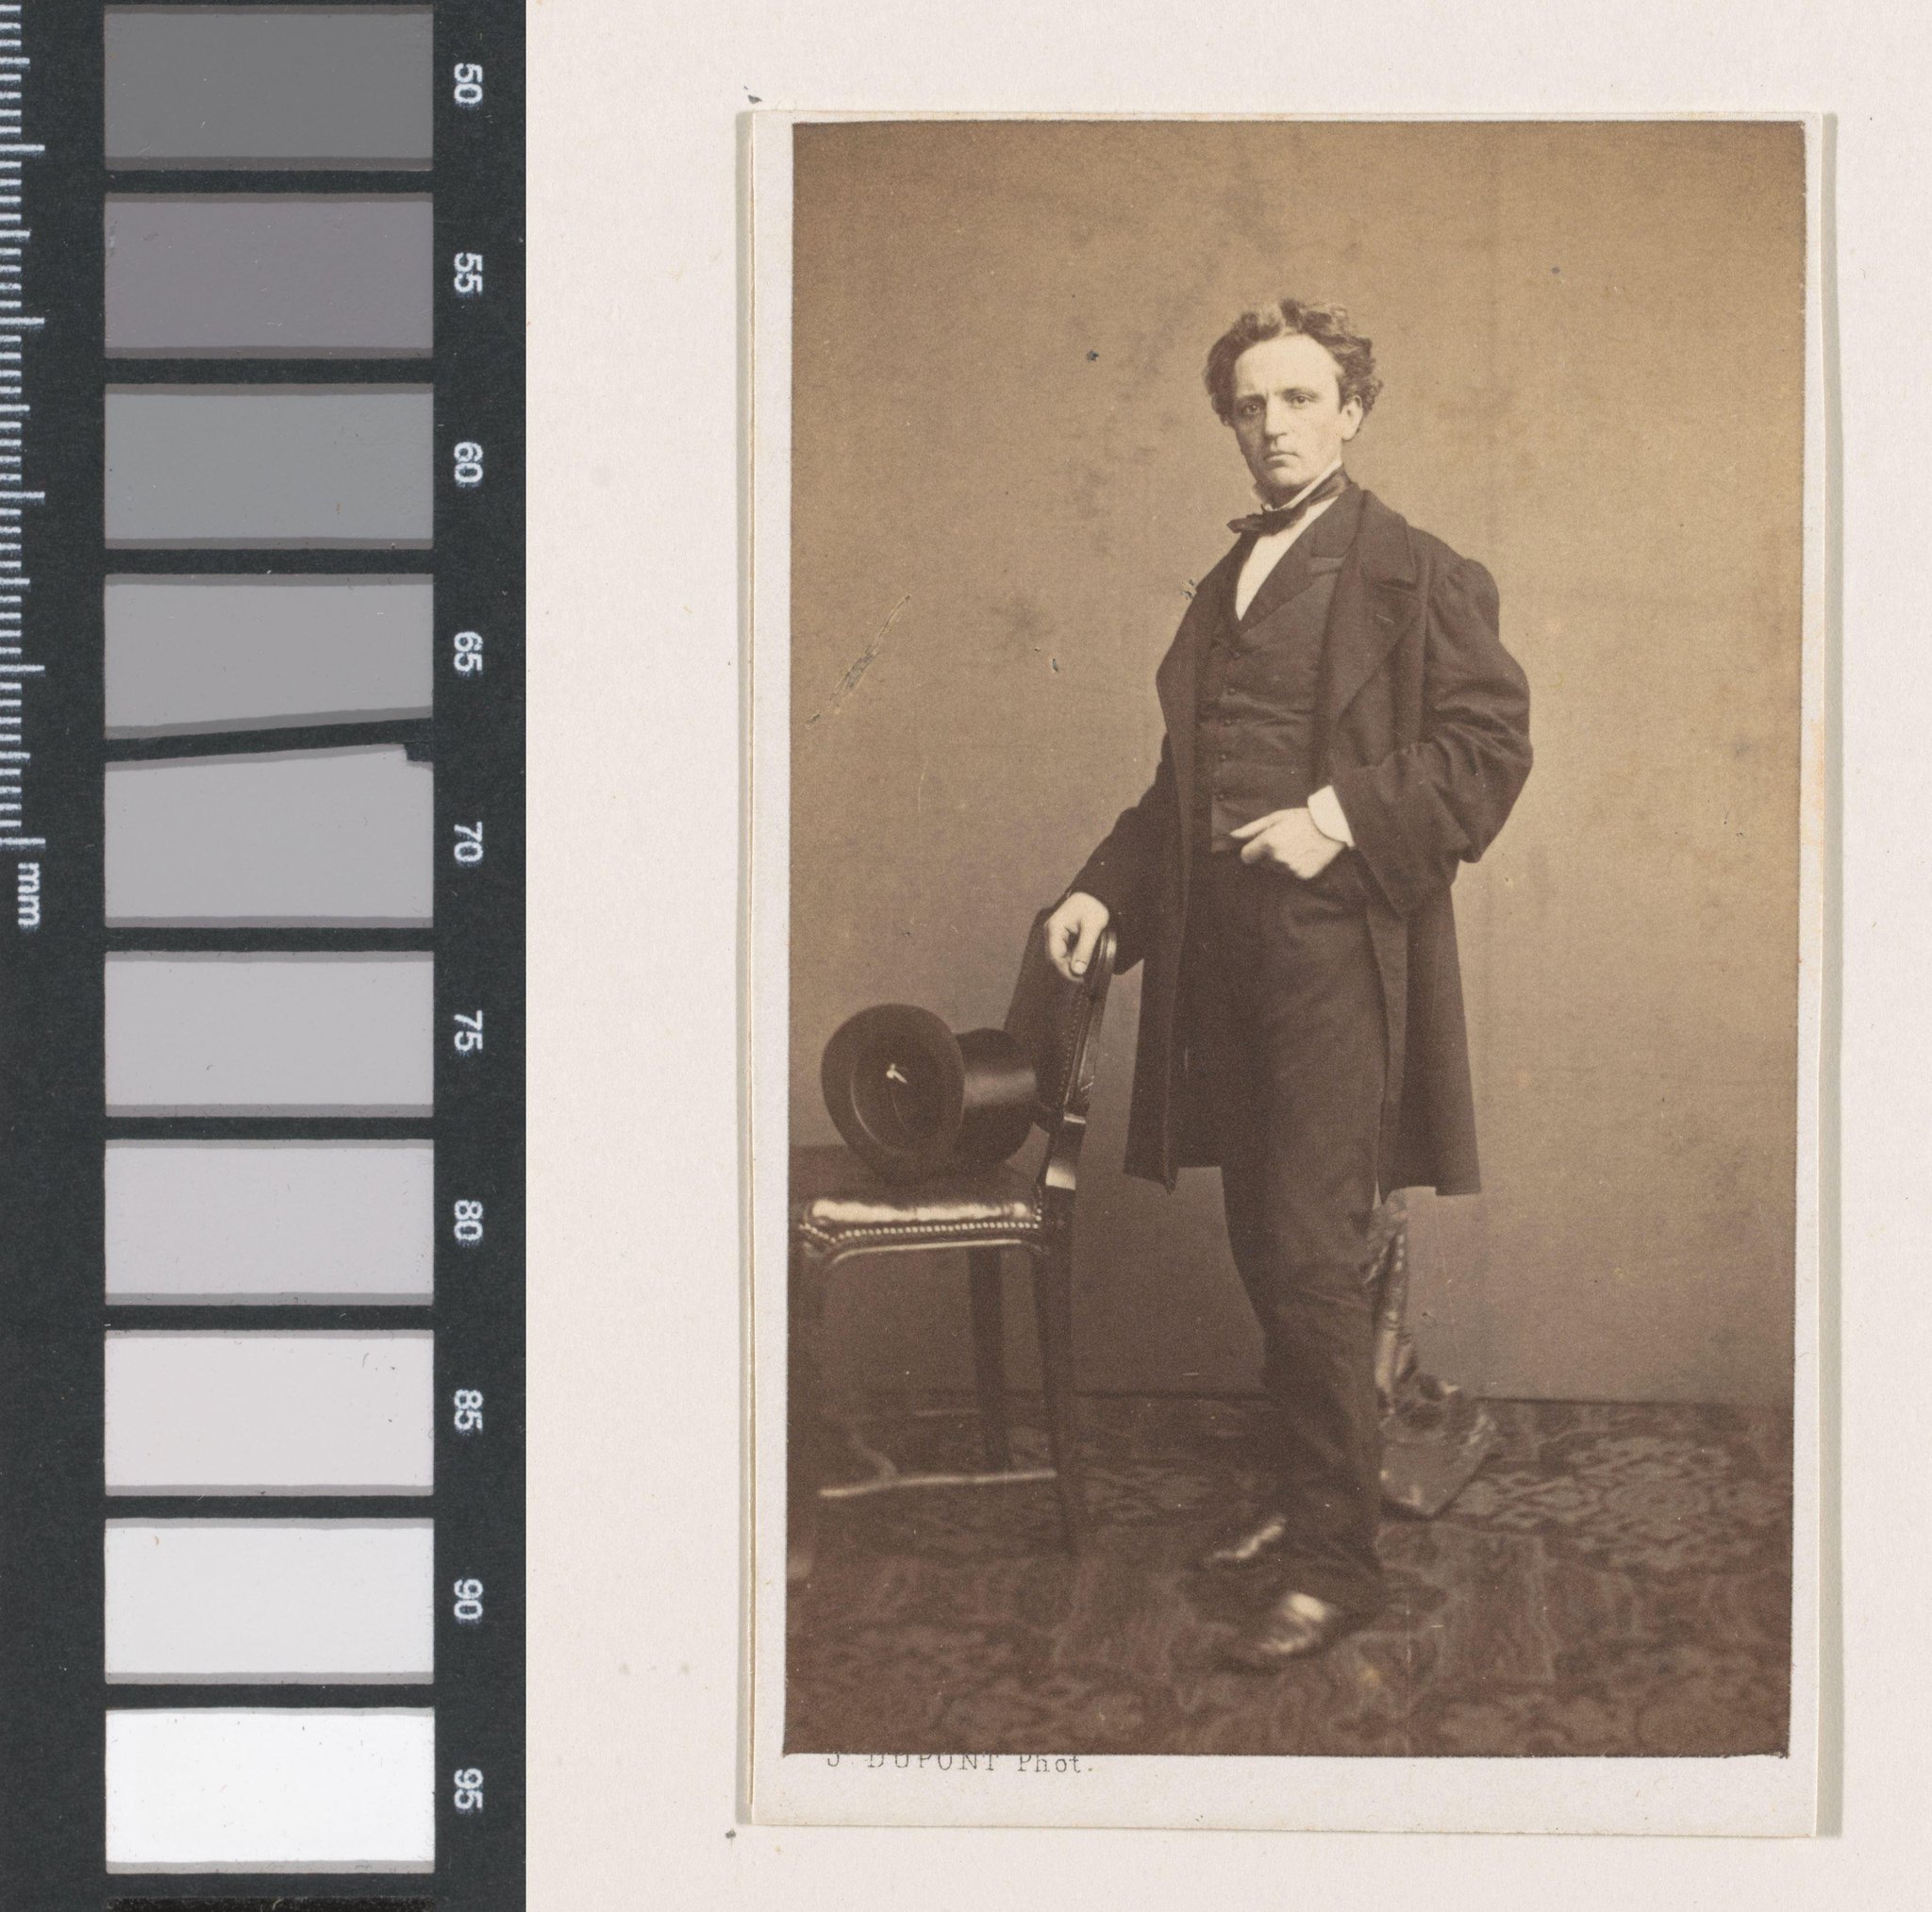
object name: photograph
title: L'École d'Anvers. Portraits biographies cartes de visite. Collection Dupont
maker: joseph dupont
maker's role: fotograaf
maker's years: 1818-1901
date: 1861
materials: cardboard, paper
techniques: albumen print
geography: antwerp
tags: the hague, antwerp, painter, print maker, huib van hove bz, historical persons, portrait, self-portrait of painter, portrait, self-portrait of artist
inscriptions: inscription: ‘ETABLISSEMENT PHOTOGRAPHIQUE/ de/ J. DUPONT/ Place de Meir 32/ ANVERS/ Maison fondée en 1853’